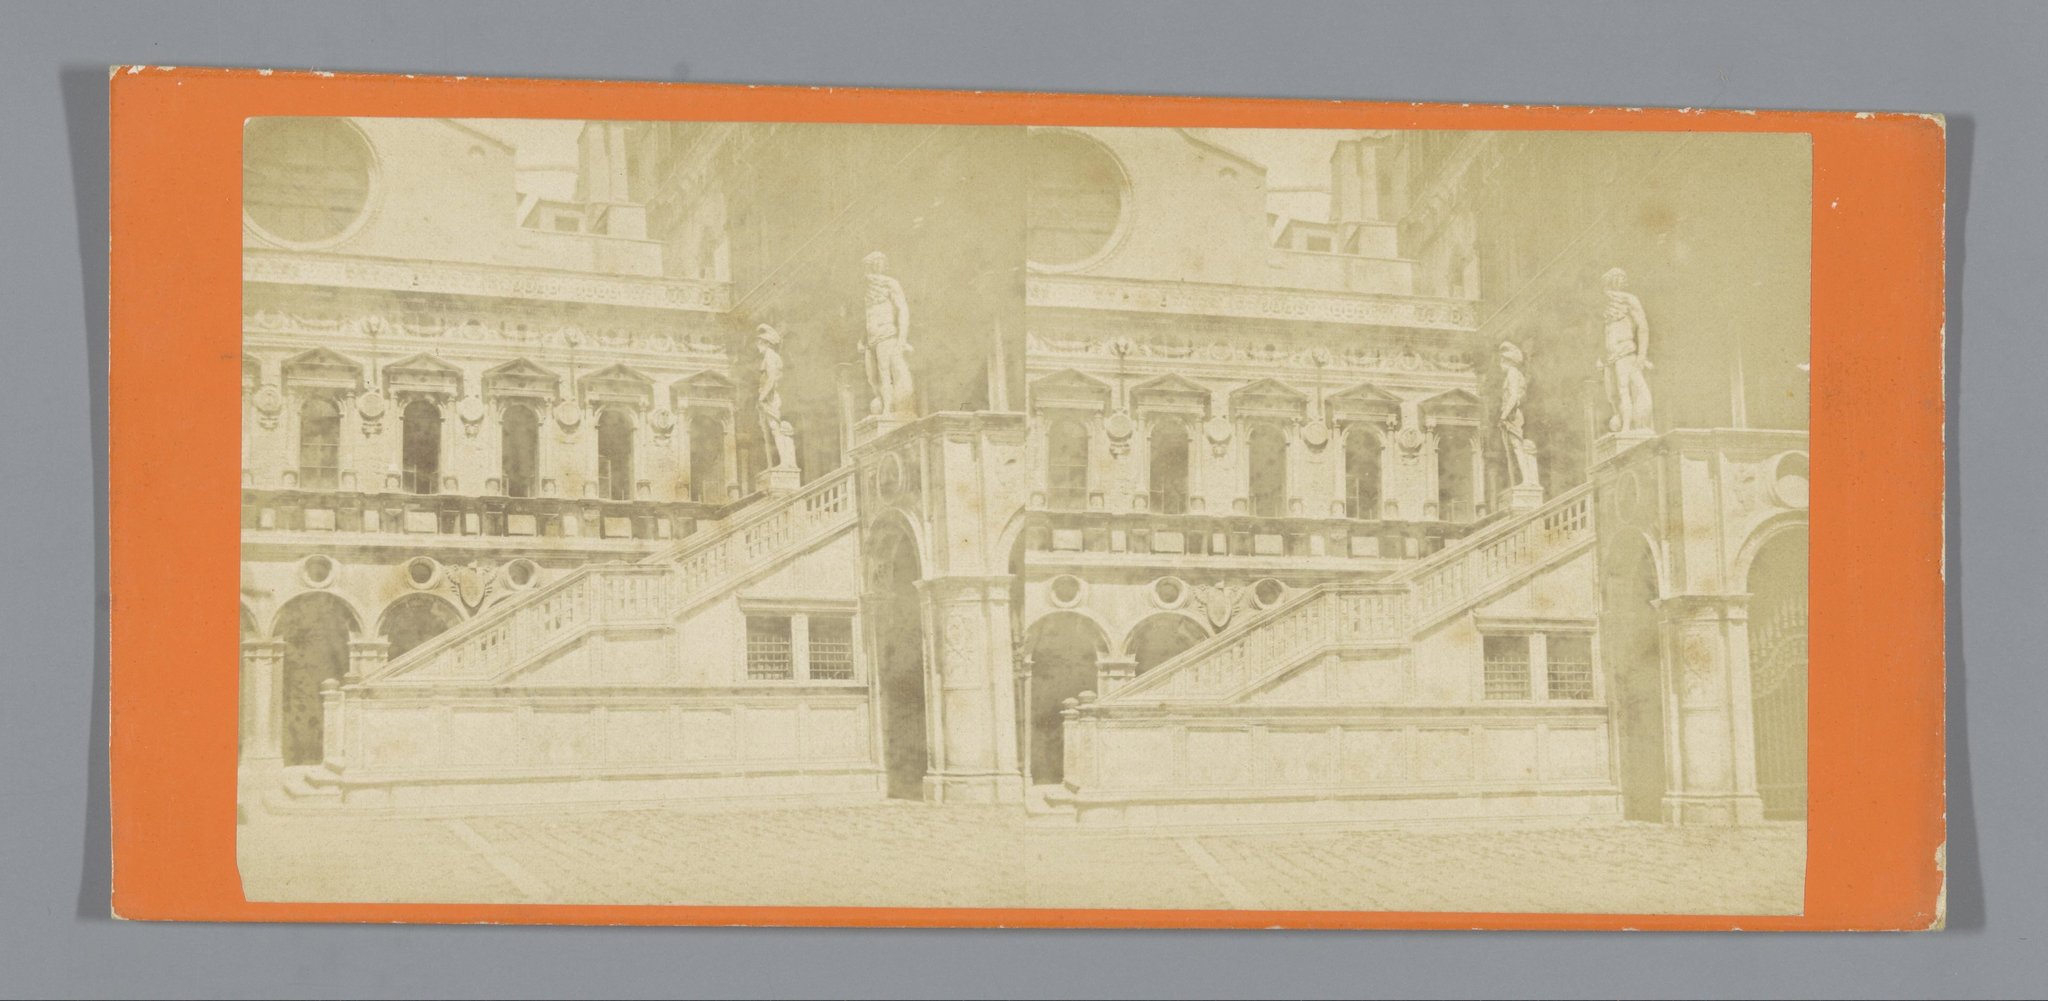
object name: stereograph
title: Scala dei Giganti op de binnenplaats van het Dogenpaleis te Venetië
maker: Anonymous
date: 1850-1880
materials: cardboard, photographic support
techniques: albumen print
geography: venice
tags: staircase, sculpture, inner court of palace or 'hôtel'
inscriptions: inscription: ‘Escalier des geants, vu de côté Venise’